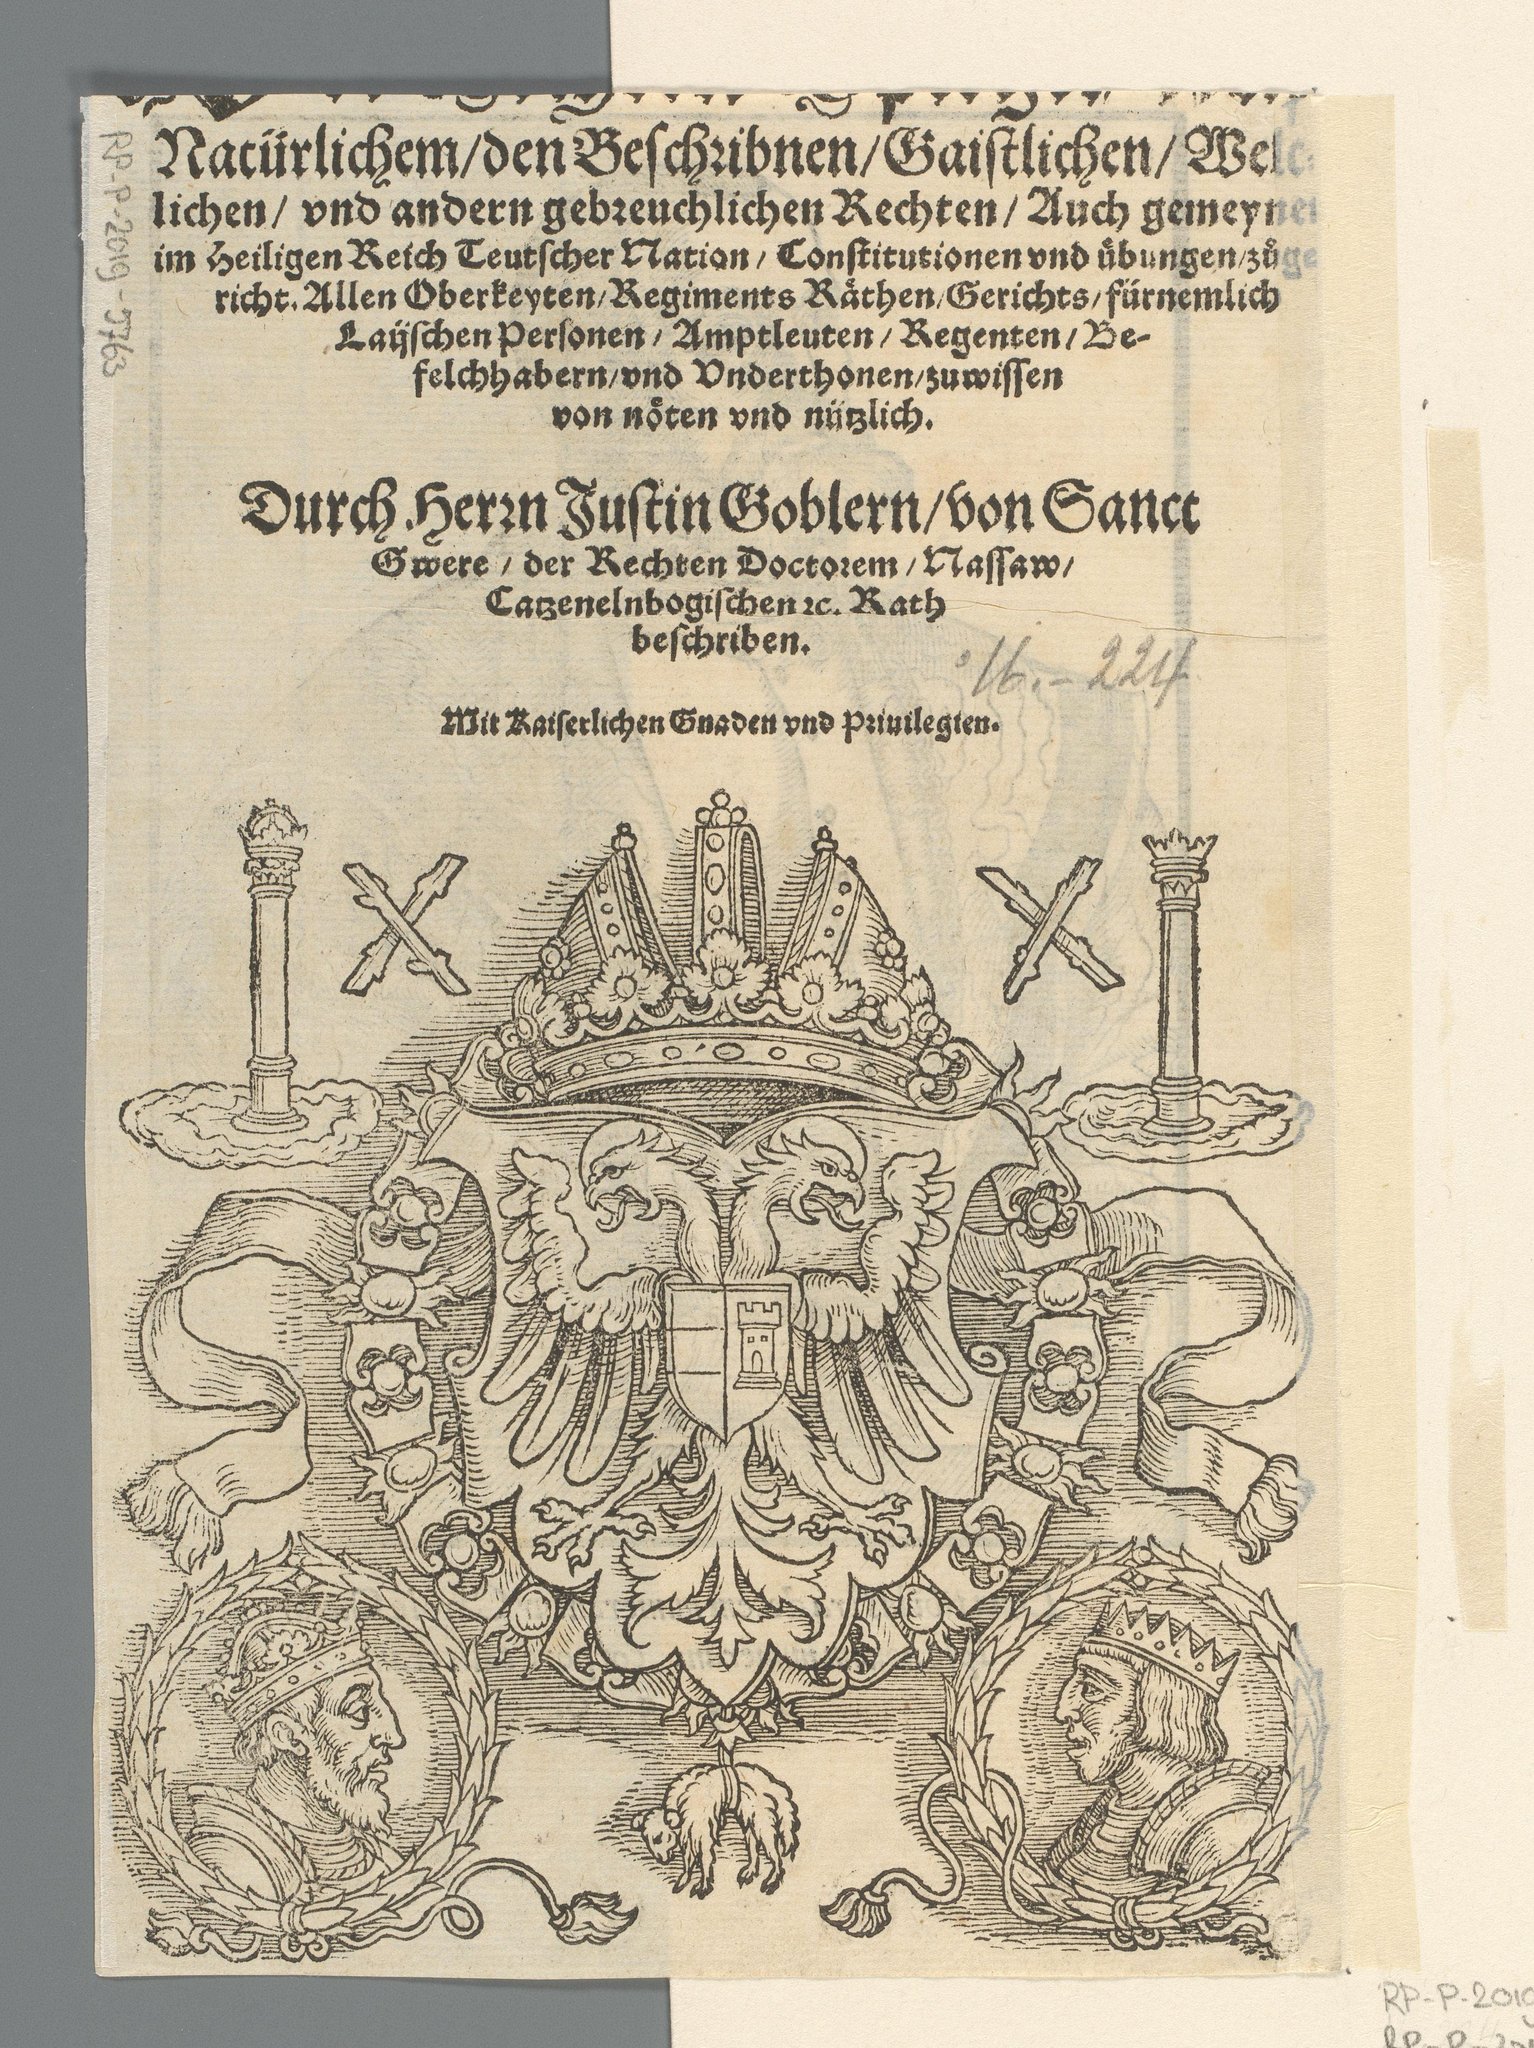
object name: print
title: Portret van François de Créquy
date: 1670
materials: paper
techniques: engraving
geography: vienna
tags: paris, historical persons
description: Prent gebruikt in: Gualdo Priorato, Galeazzo. Historia di Leopoldo Cesare (...). 2 dln. Wenen: Giovanni Battista Hacque, 1670.